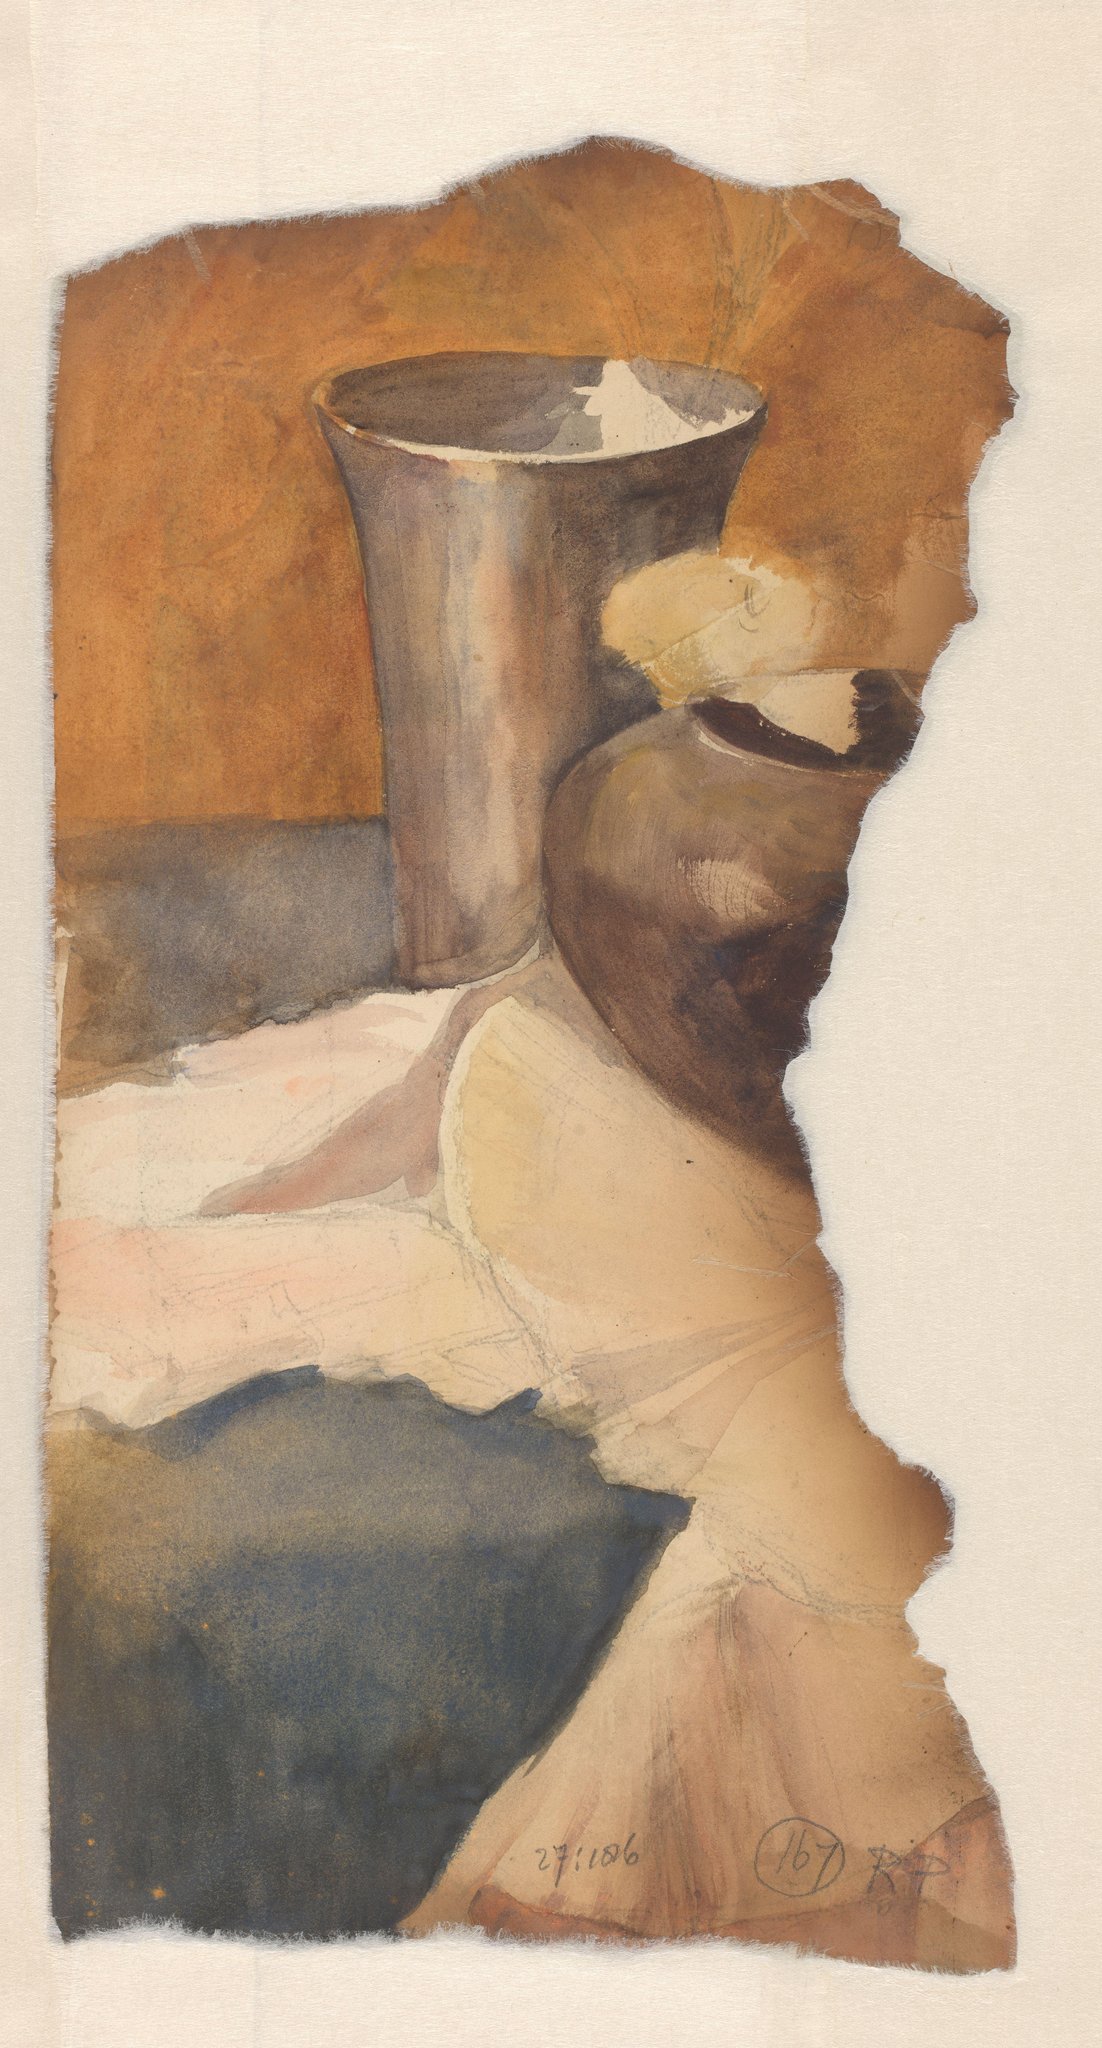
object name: drawing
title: Stilleven (fragment)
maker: julie de graag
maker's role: draughtsman, print maker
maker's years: 1877-1924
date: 1887-1924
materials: paper, pencil, watercolor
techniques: brush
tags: still life of related objects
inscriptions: inscription: ‘R.P.’, number: ‘167’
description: Fragment van een stilleven met twee vazen.